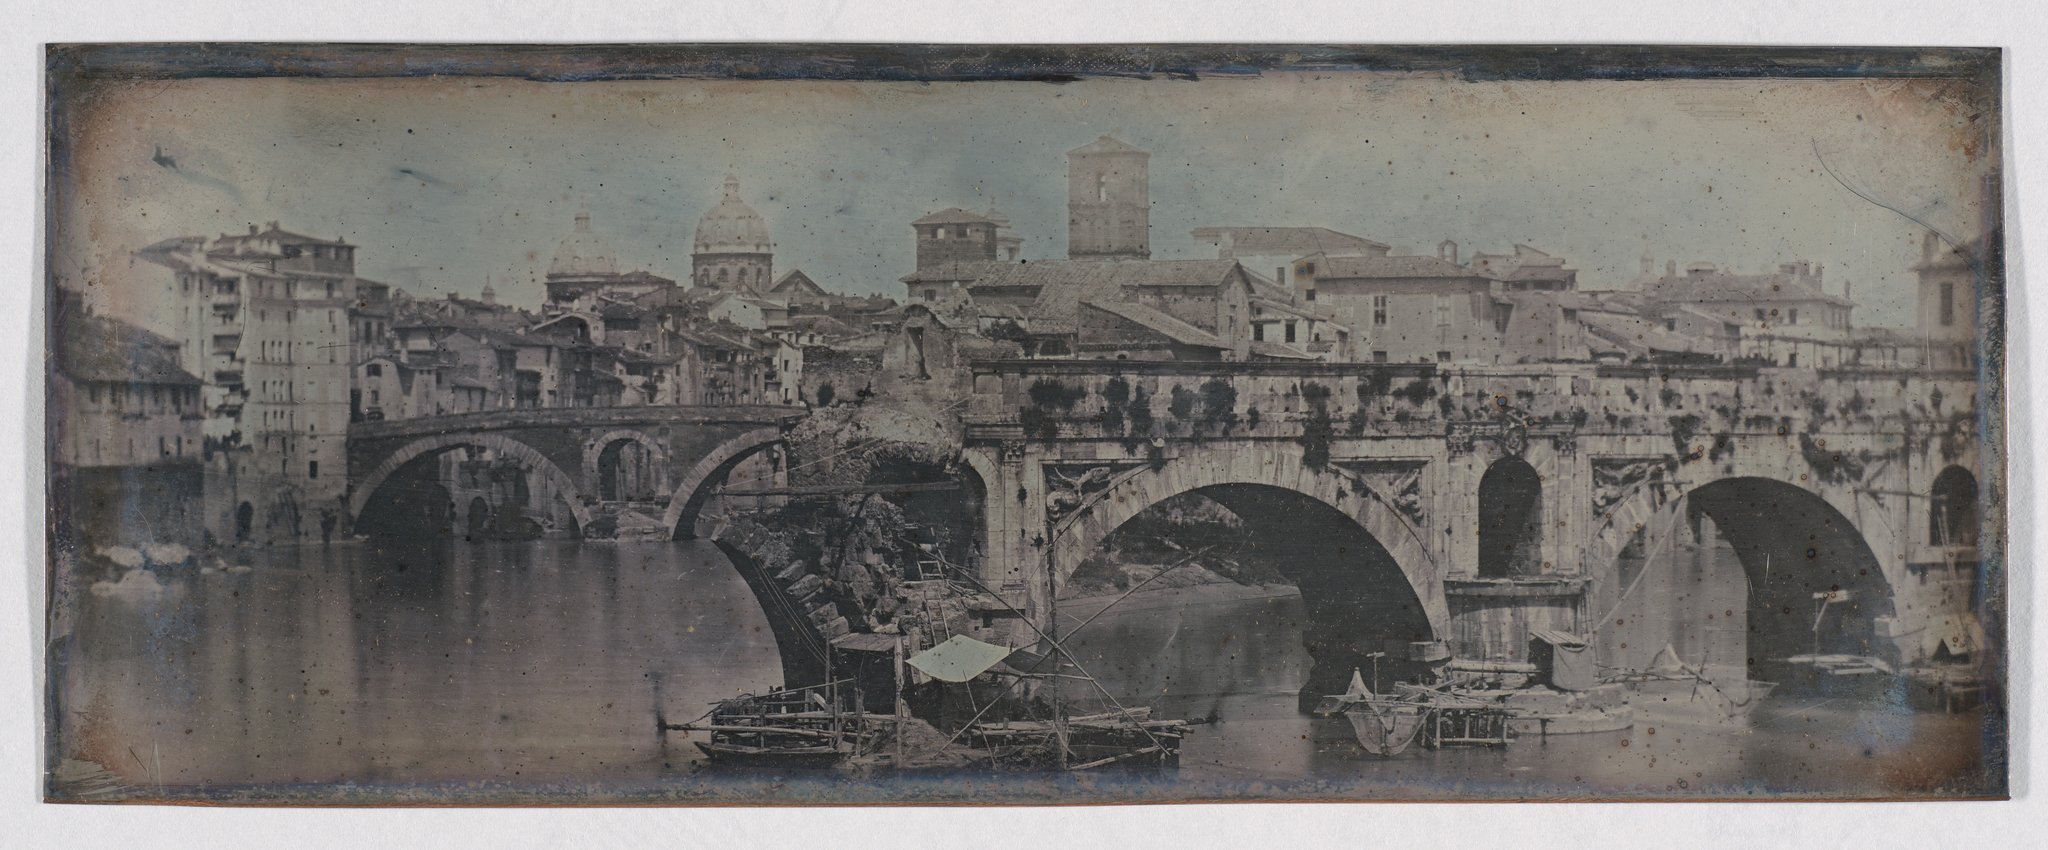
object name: photograph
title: Ponte Rotto (Pons Aemilius), Rome (31. Rome. 1842. Ponte Rotto.)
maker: joseph-philibert girault de prangey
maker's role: artist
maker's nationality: french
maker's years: 1804-1892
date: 1842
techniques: daguerreotype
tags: buildings,cities,bridges,rivers